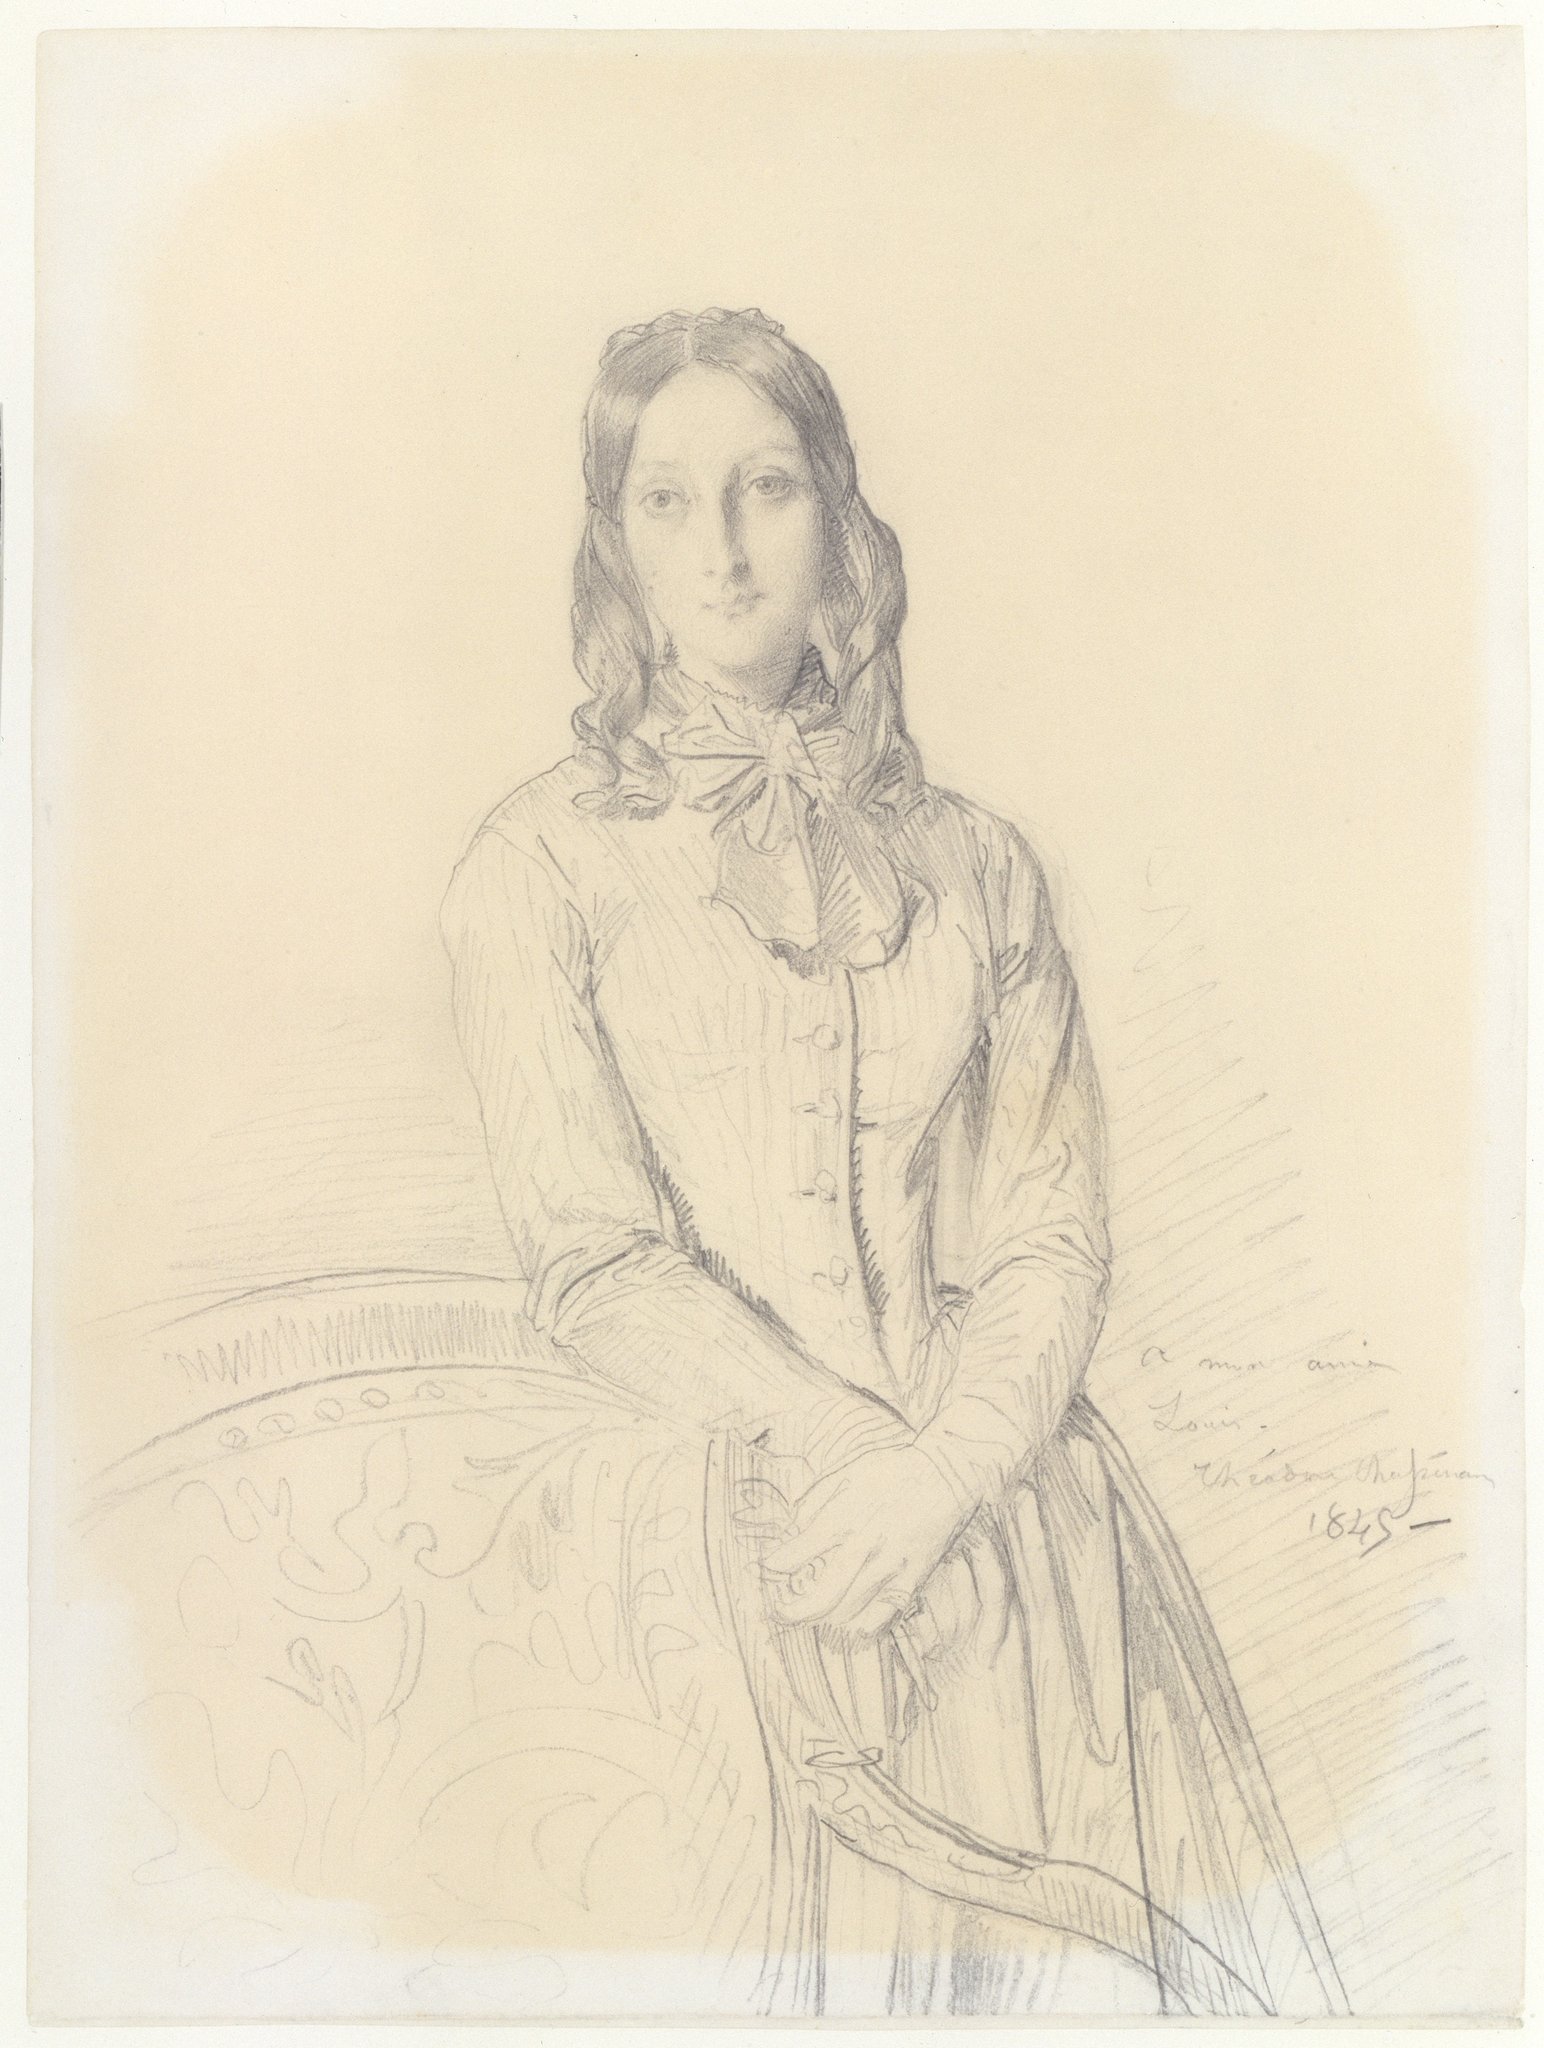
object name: drawing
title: Portrait of Madame Gabrielle Marcotte de Quivières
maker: théodore chassériau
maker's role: artist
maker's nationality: french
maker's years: 1819-1856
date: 1845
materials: graphite, paper